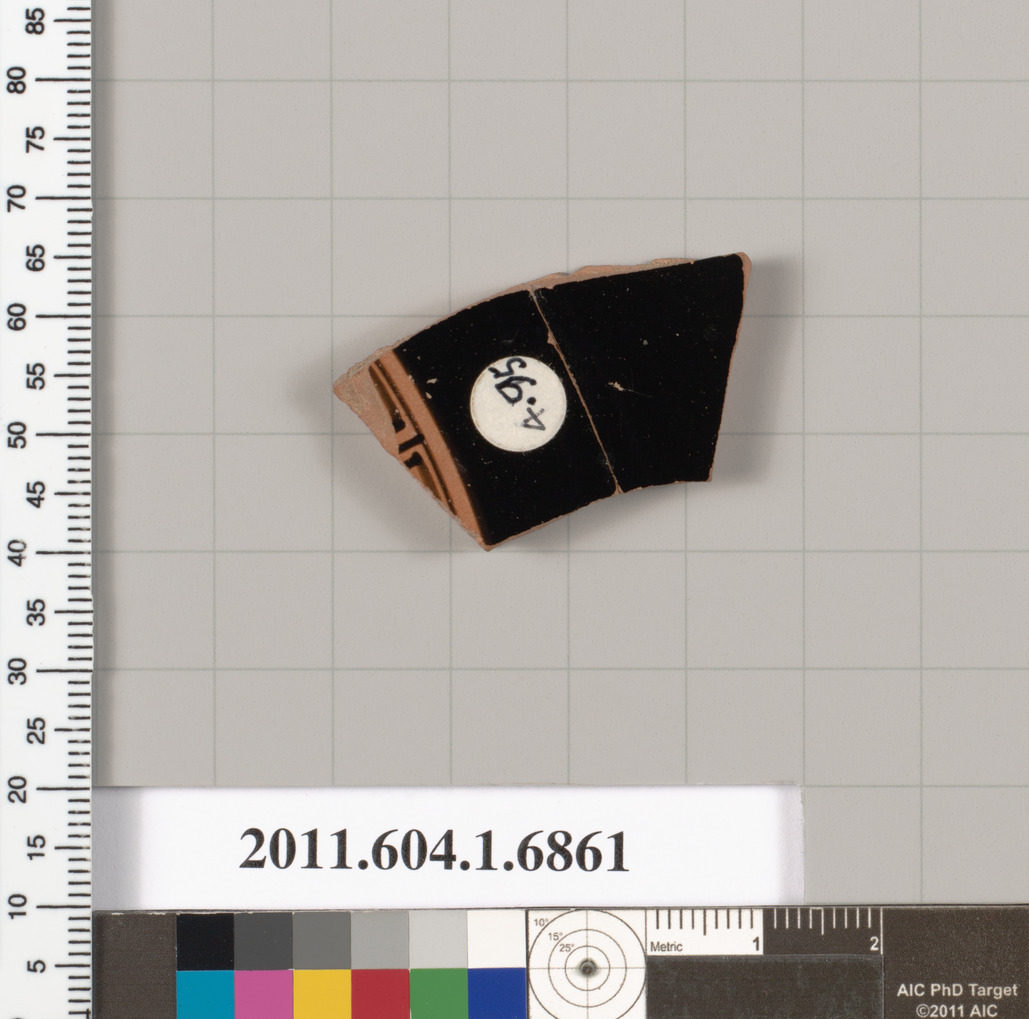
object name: kylix fragment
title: Terracotta fragment of a kylix (drinking cup)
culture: greek, attic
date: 490-470 BCE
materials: terracotta